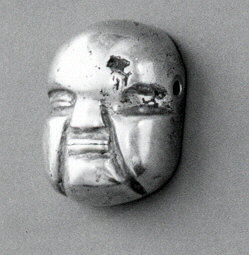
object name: ornament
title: Gold Necklace Ornament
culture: colombian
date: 201-1600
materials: gold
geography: colombia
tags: heads